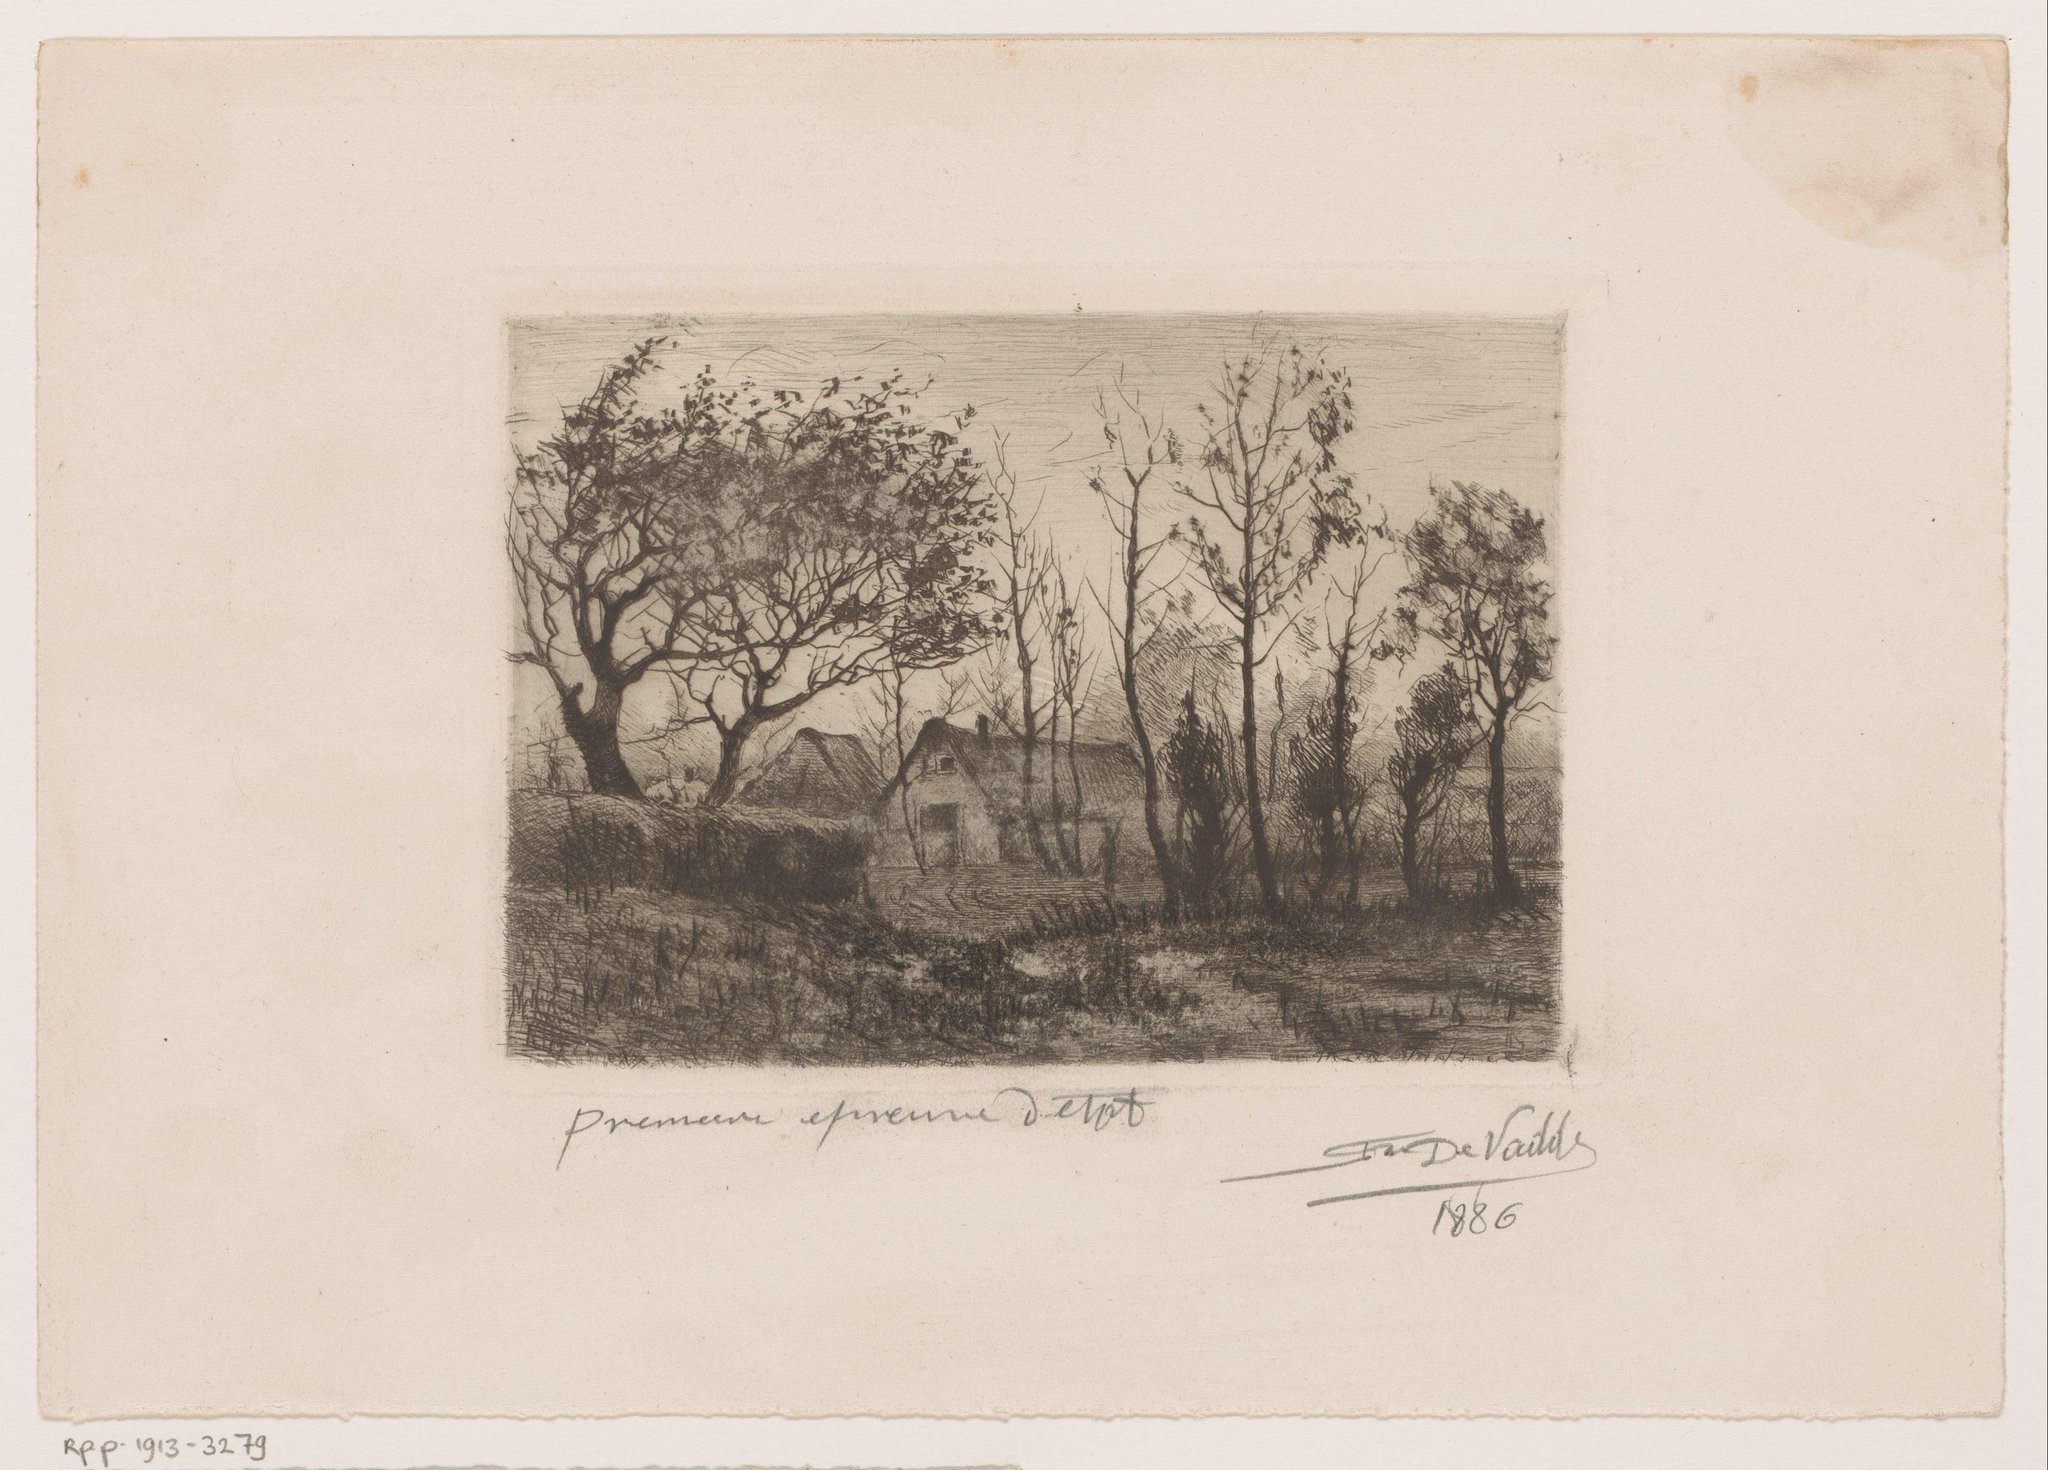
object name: print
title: Figuur loopt richting enkele huizen in het landschap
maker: frans de vadder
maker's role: print maker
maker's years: 1862-1936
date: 1886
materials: paper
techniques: drypoint, etching, retroussage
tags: farm or solitary house in landscape (+ city(-scape) with figures, staffage)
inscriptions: inscription: ‘Premiere epreuve d etat; 1886’, collector's mark: Lugt 2228